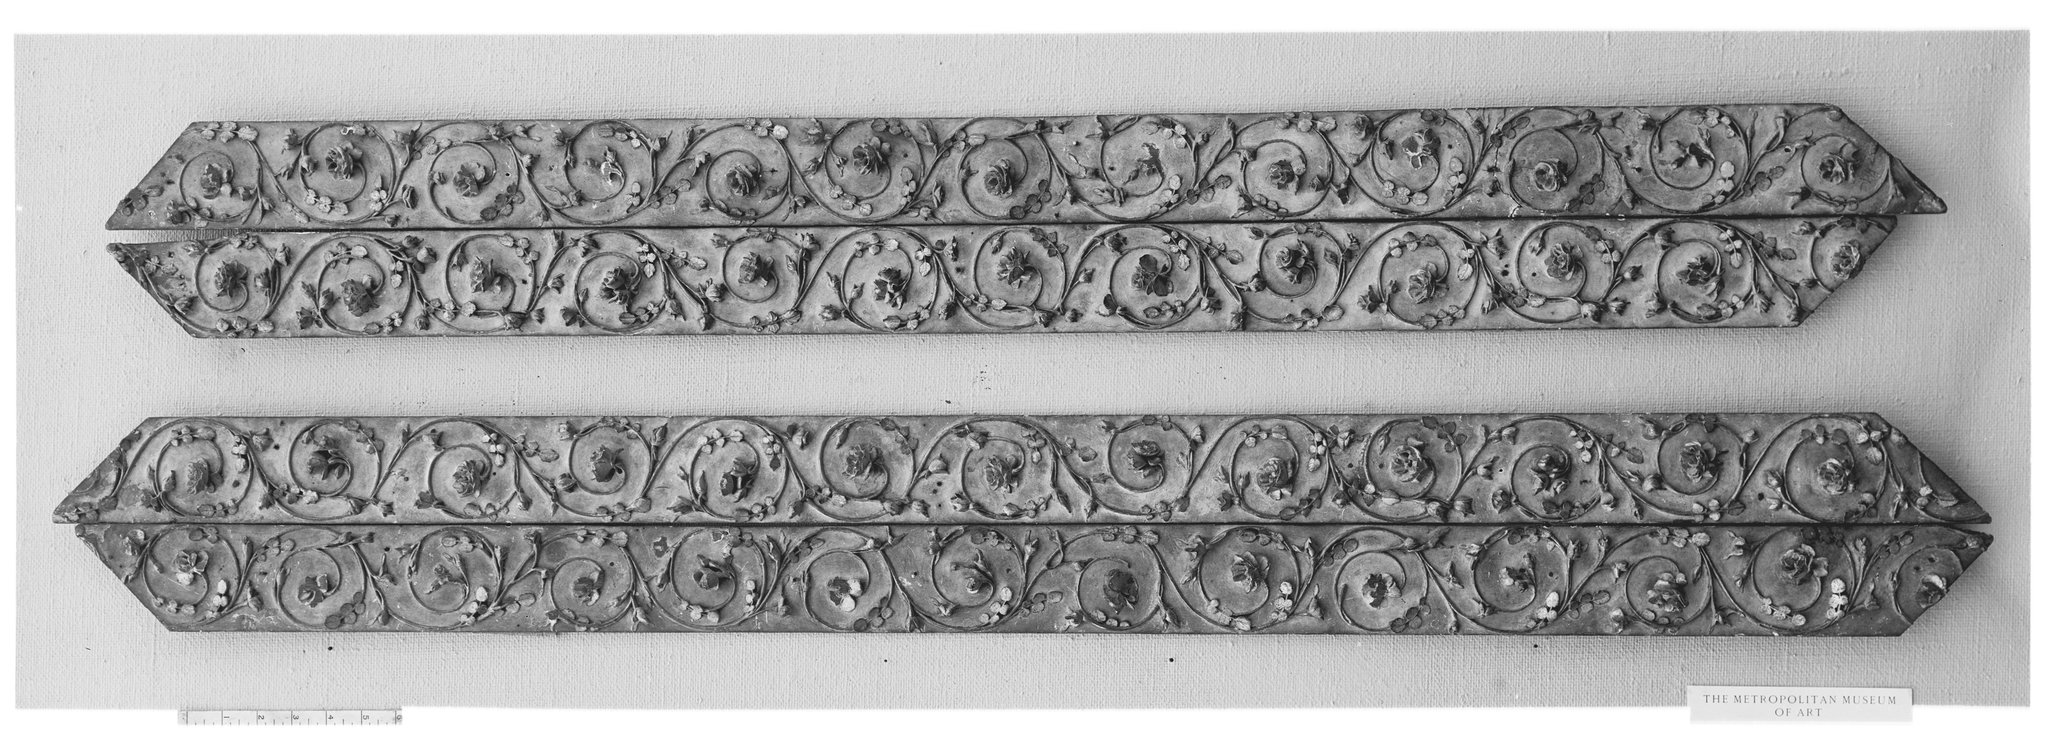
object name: frieze panel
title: Set of frieze panels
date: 1701-1800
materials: gilt, wood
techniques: carving